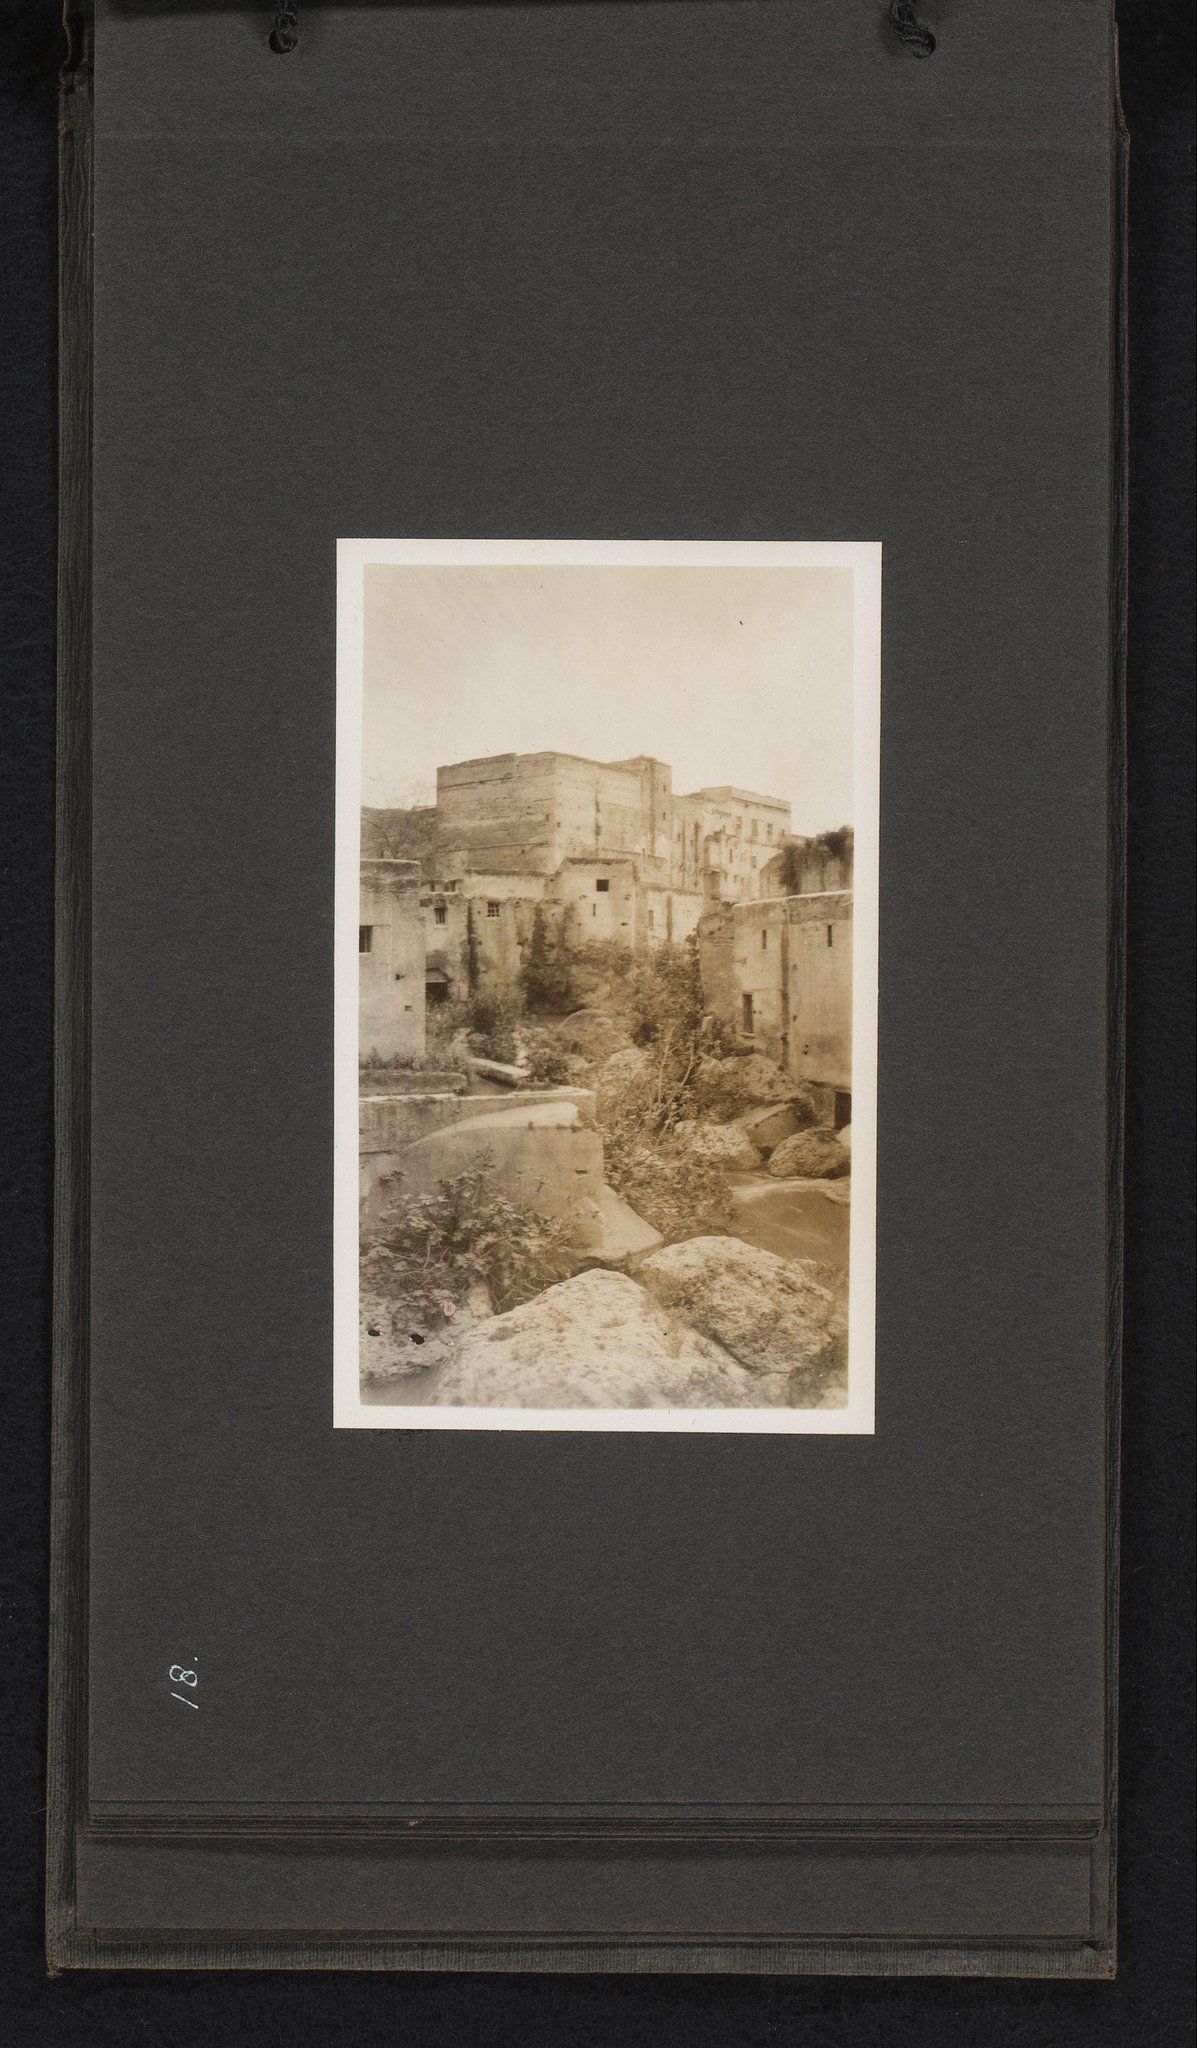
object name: photograph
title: Gezicht op El Maiz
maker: a.g.a. van eelde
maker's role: engineer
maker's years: 1862-1950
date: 1927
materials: paper, photographic support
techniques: gelatin silver print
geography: figuig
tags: city-view, and landscape with man-made constructions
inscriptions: number: ‘18.’